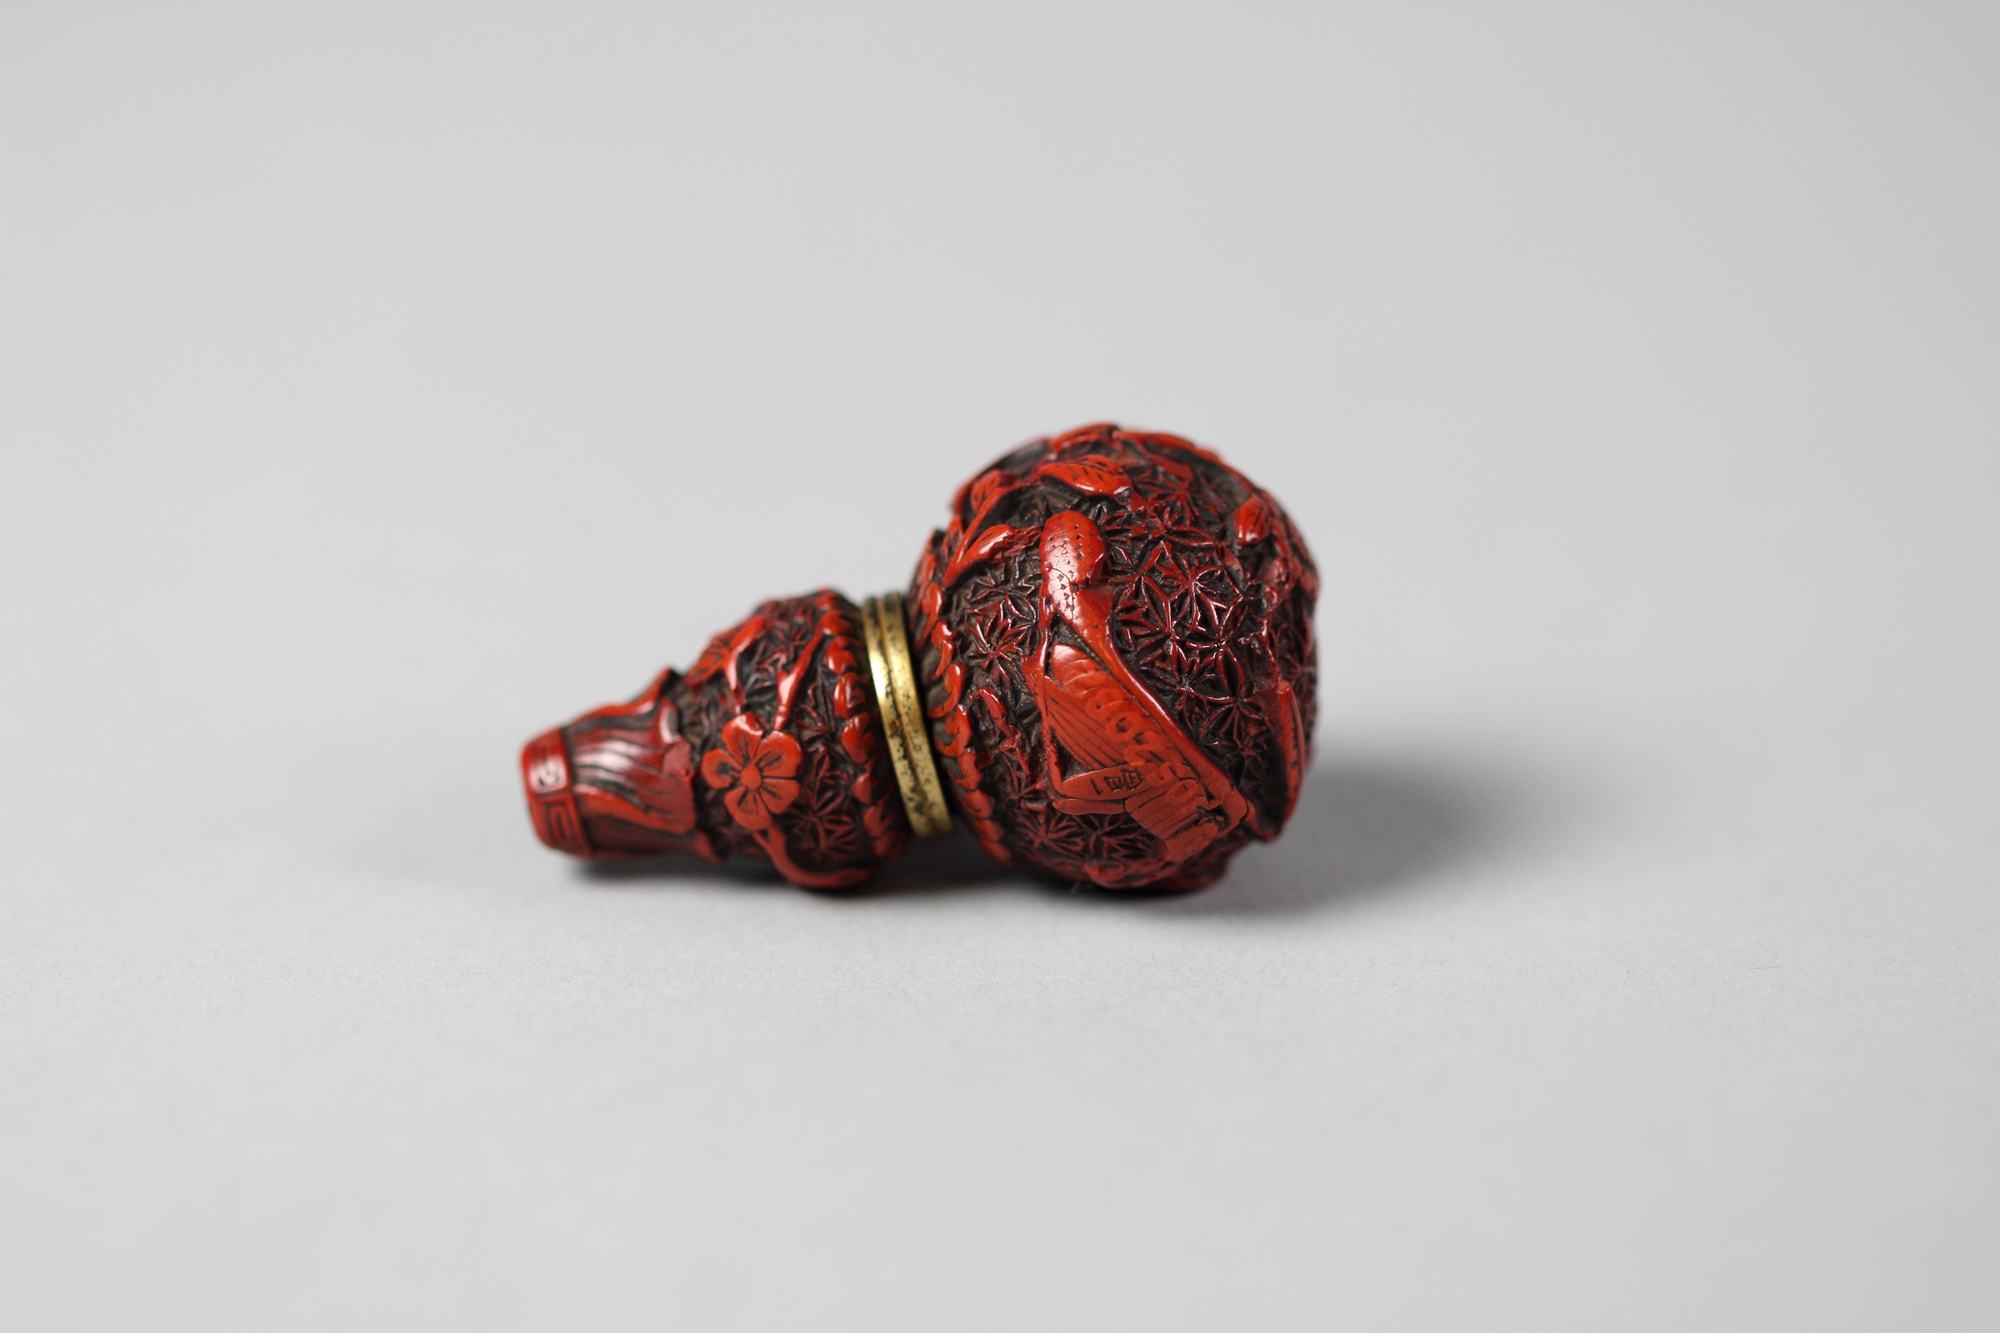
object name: netsuke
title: Netsuke of Double-Gourd Shape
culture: japanese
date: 1801-1900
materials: lacquer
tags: insects